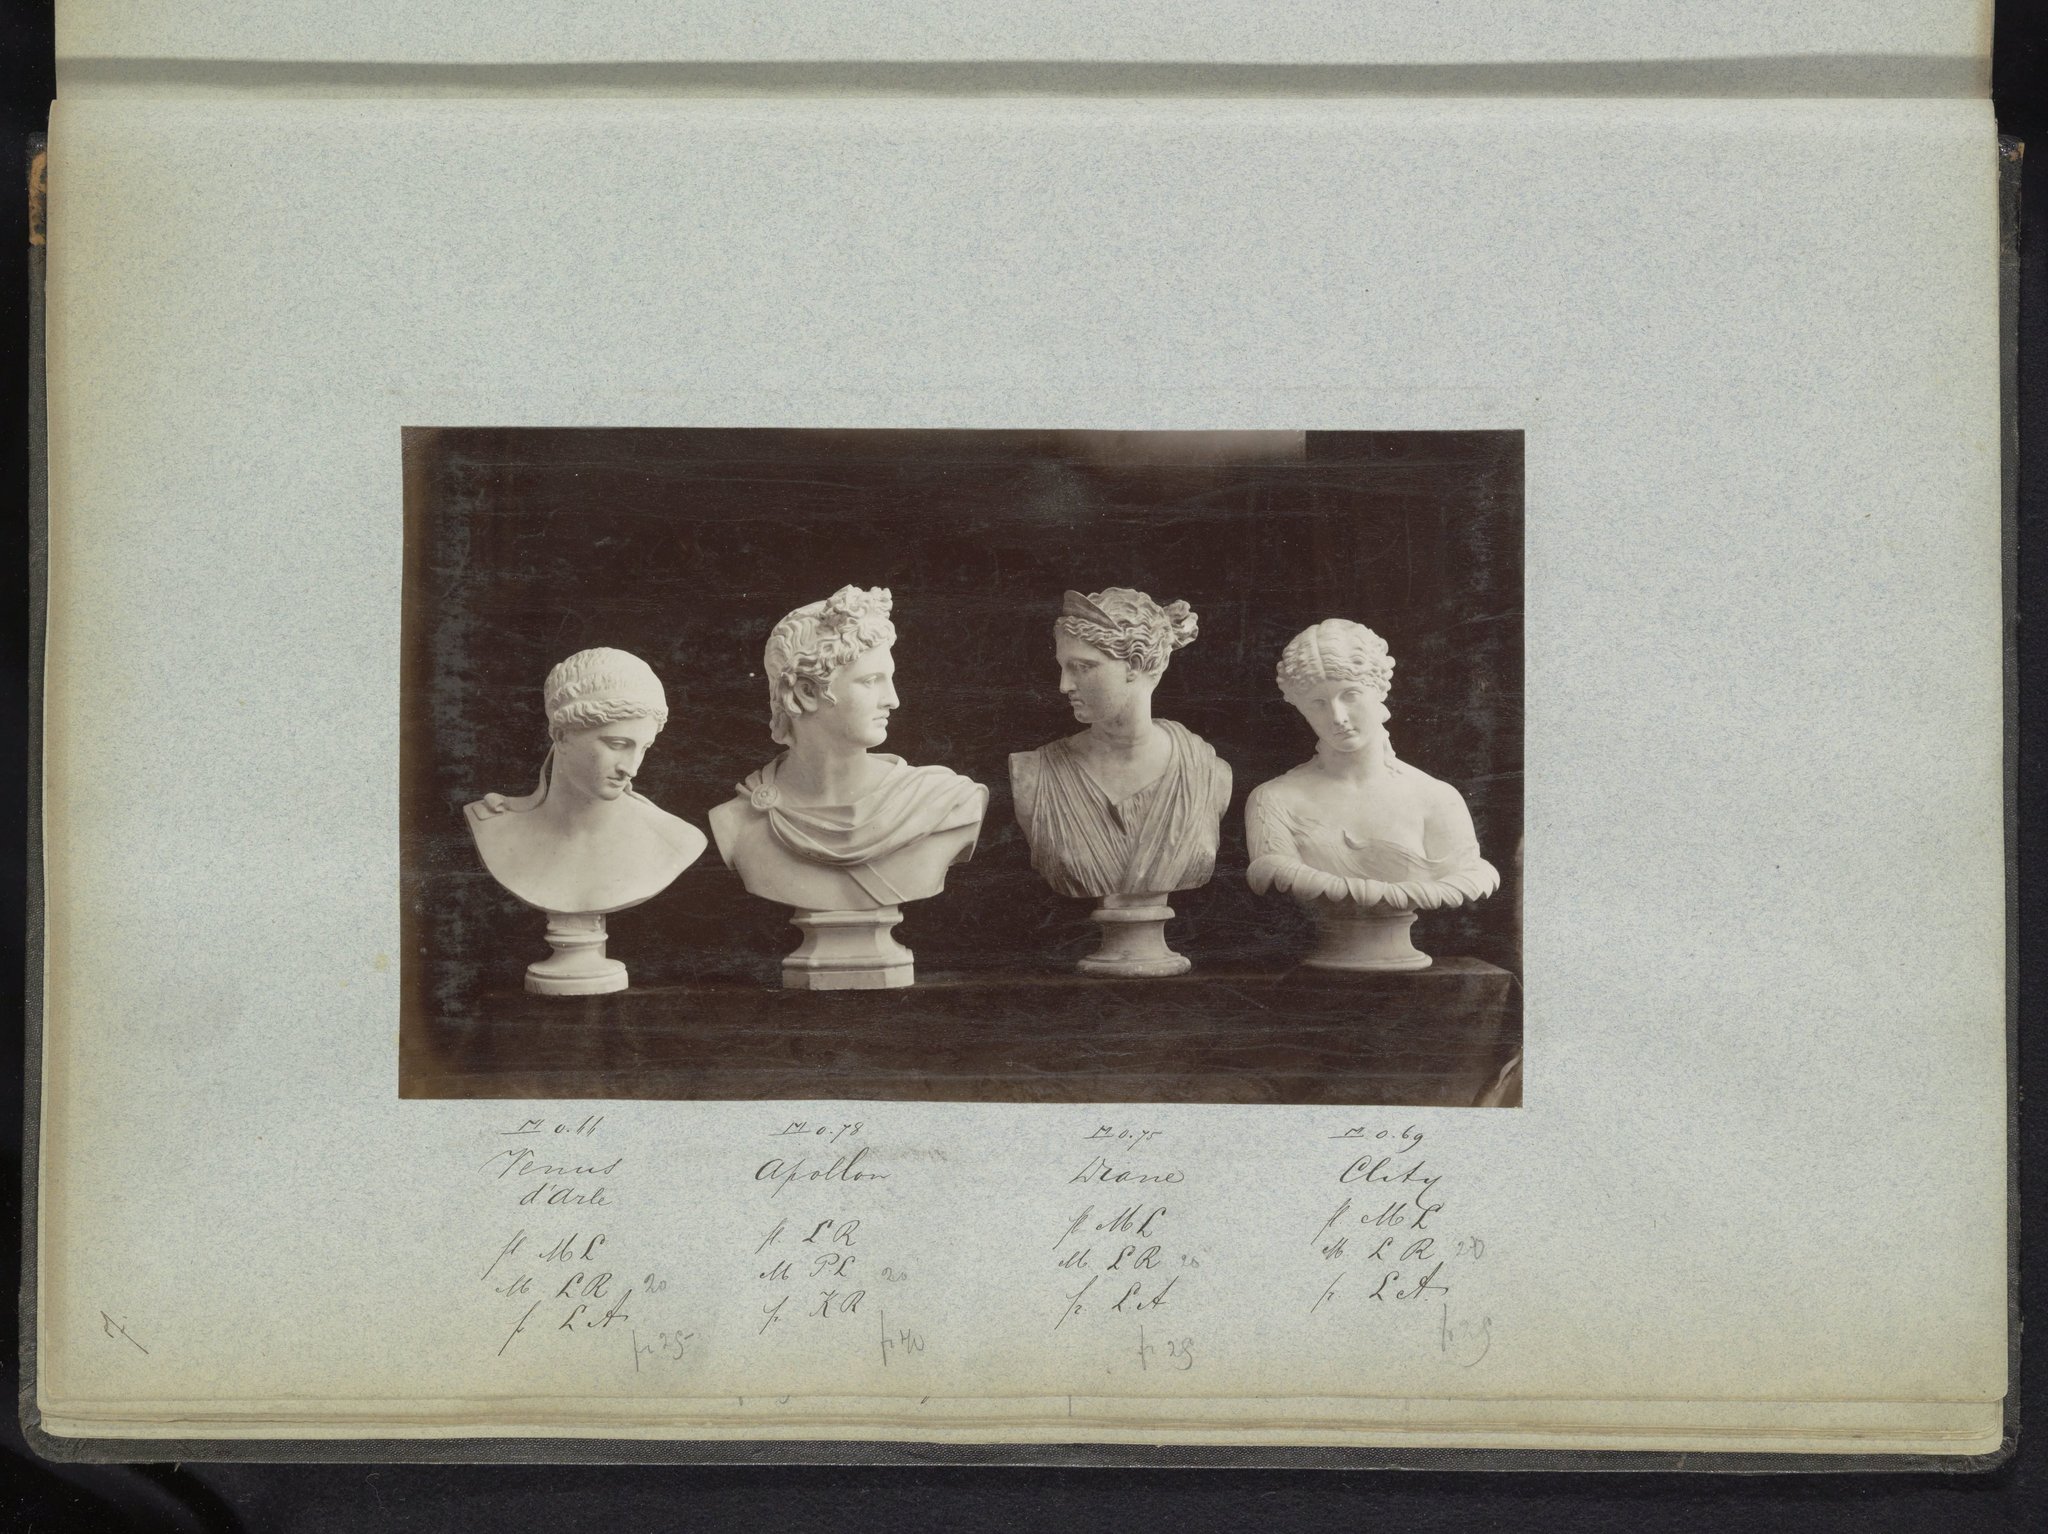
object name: album leaf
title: Gipsen bustes van Venus, Apollo, Diane, en [...]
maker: Anonymous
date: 1875-1900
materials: paper, photographic support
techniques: albumen print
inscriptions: annotation: ‘Clity [?]’, annotation: ‘M 0.66 / Venus / d'Arle’, annotation: ‘M 0.78 / Apollo’, annotation, annotation: ‘M 0.75 / Diane’